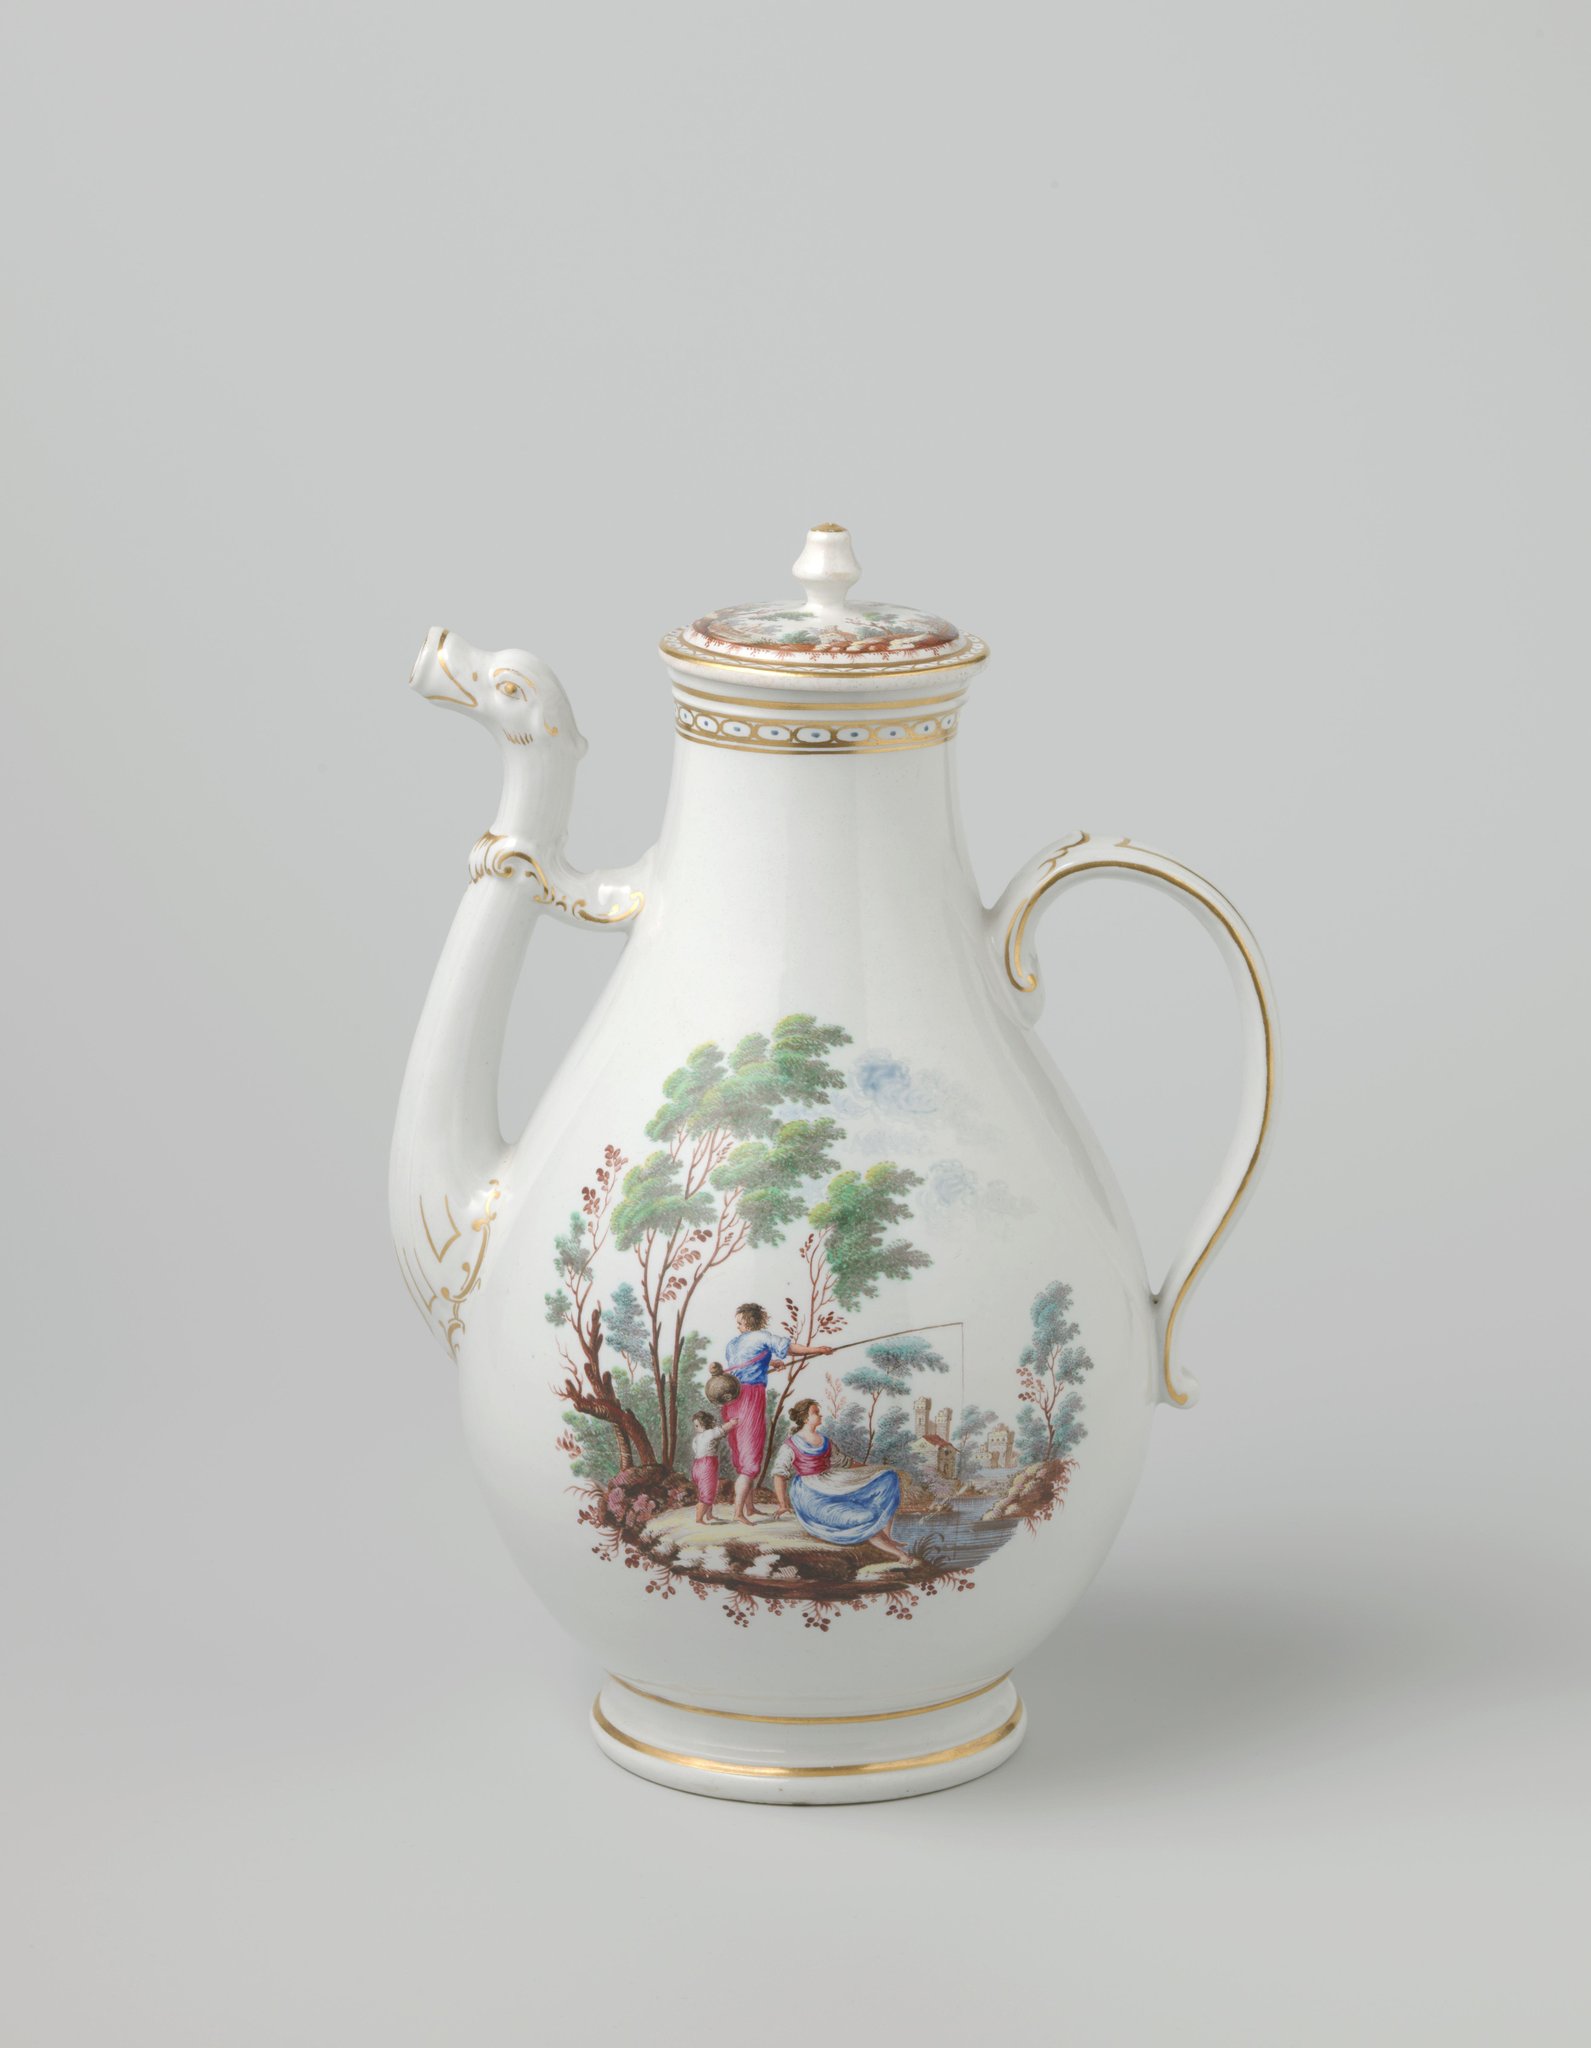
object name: coffee pot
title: Coffeepot with figures in a landscape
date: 1775-1785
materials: glaze, gold, paint, porcelain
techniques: firing, forming, gilding, turning, vitrification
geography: doccia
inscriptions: mark: ‘77’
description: Koffiekan van porselein met een peervormig lichaam, S-vormige tuit en C-vormig oor, beschilderd op het glazuur in emailkleuren en goud. Op de buitenwand tweemaal een landschap. Het ene landschap toont een staande vrouw en twee zittende mannen aan de oever bij een pilaar. Het andere landschap met een zittende vrouw en een visser met een kind achter zich. Op de nek een band van cirkels met een stip. De tuit eindigd in een dierenkop en is middels een brug verbonden met de schouder. Gouden lijnen op de voet en het oor. Gemerkt op de onderzijde met 77[?].